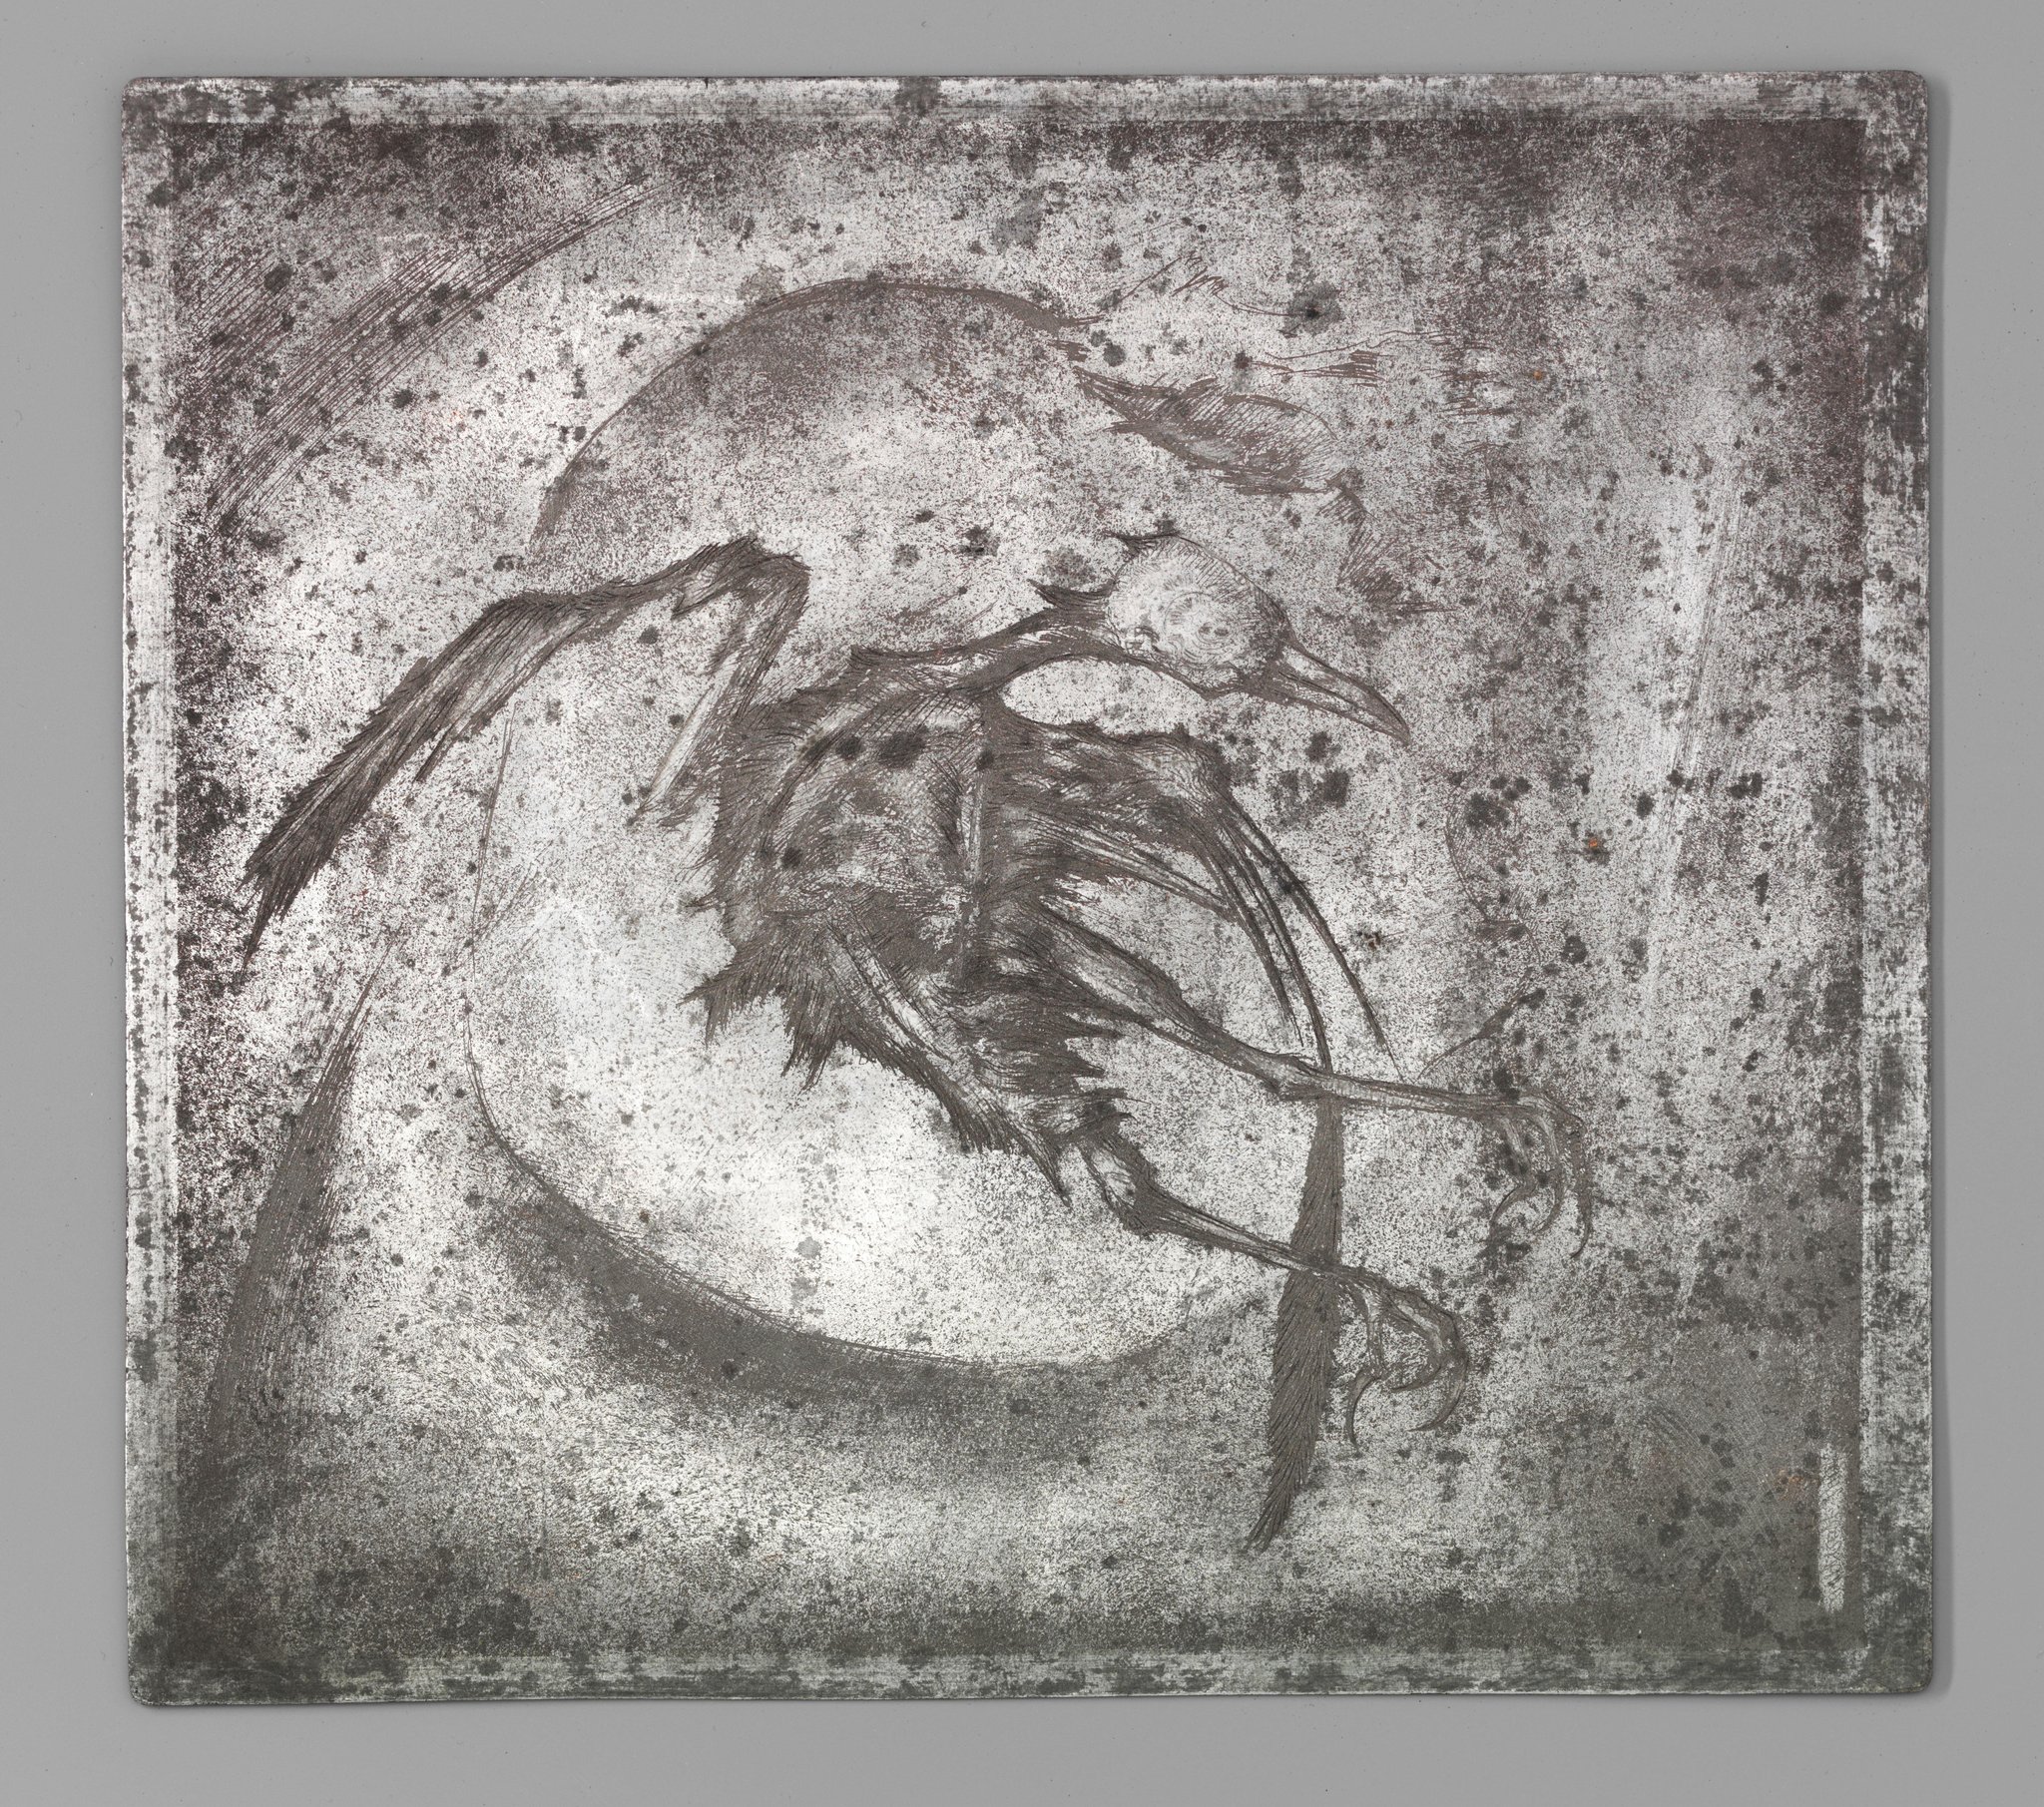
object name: zinkplaat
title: Dode vogel met schedel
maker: jan petrus ponstijn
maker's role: draughtsman, print maker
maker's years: 1883-1970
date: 1940-1948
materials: zinc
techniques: aquatint, etching